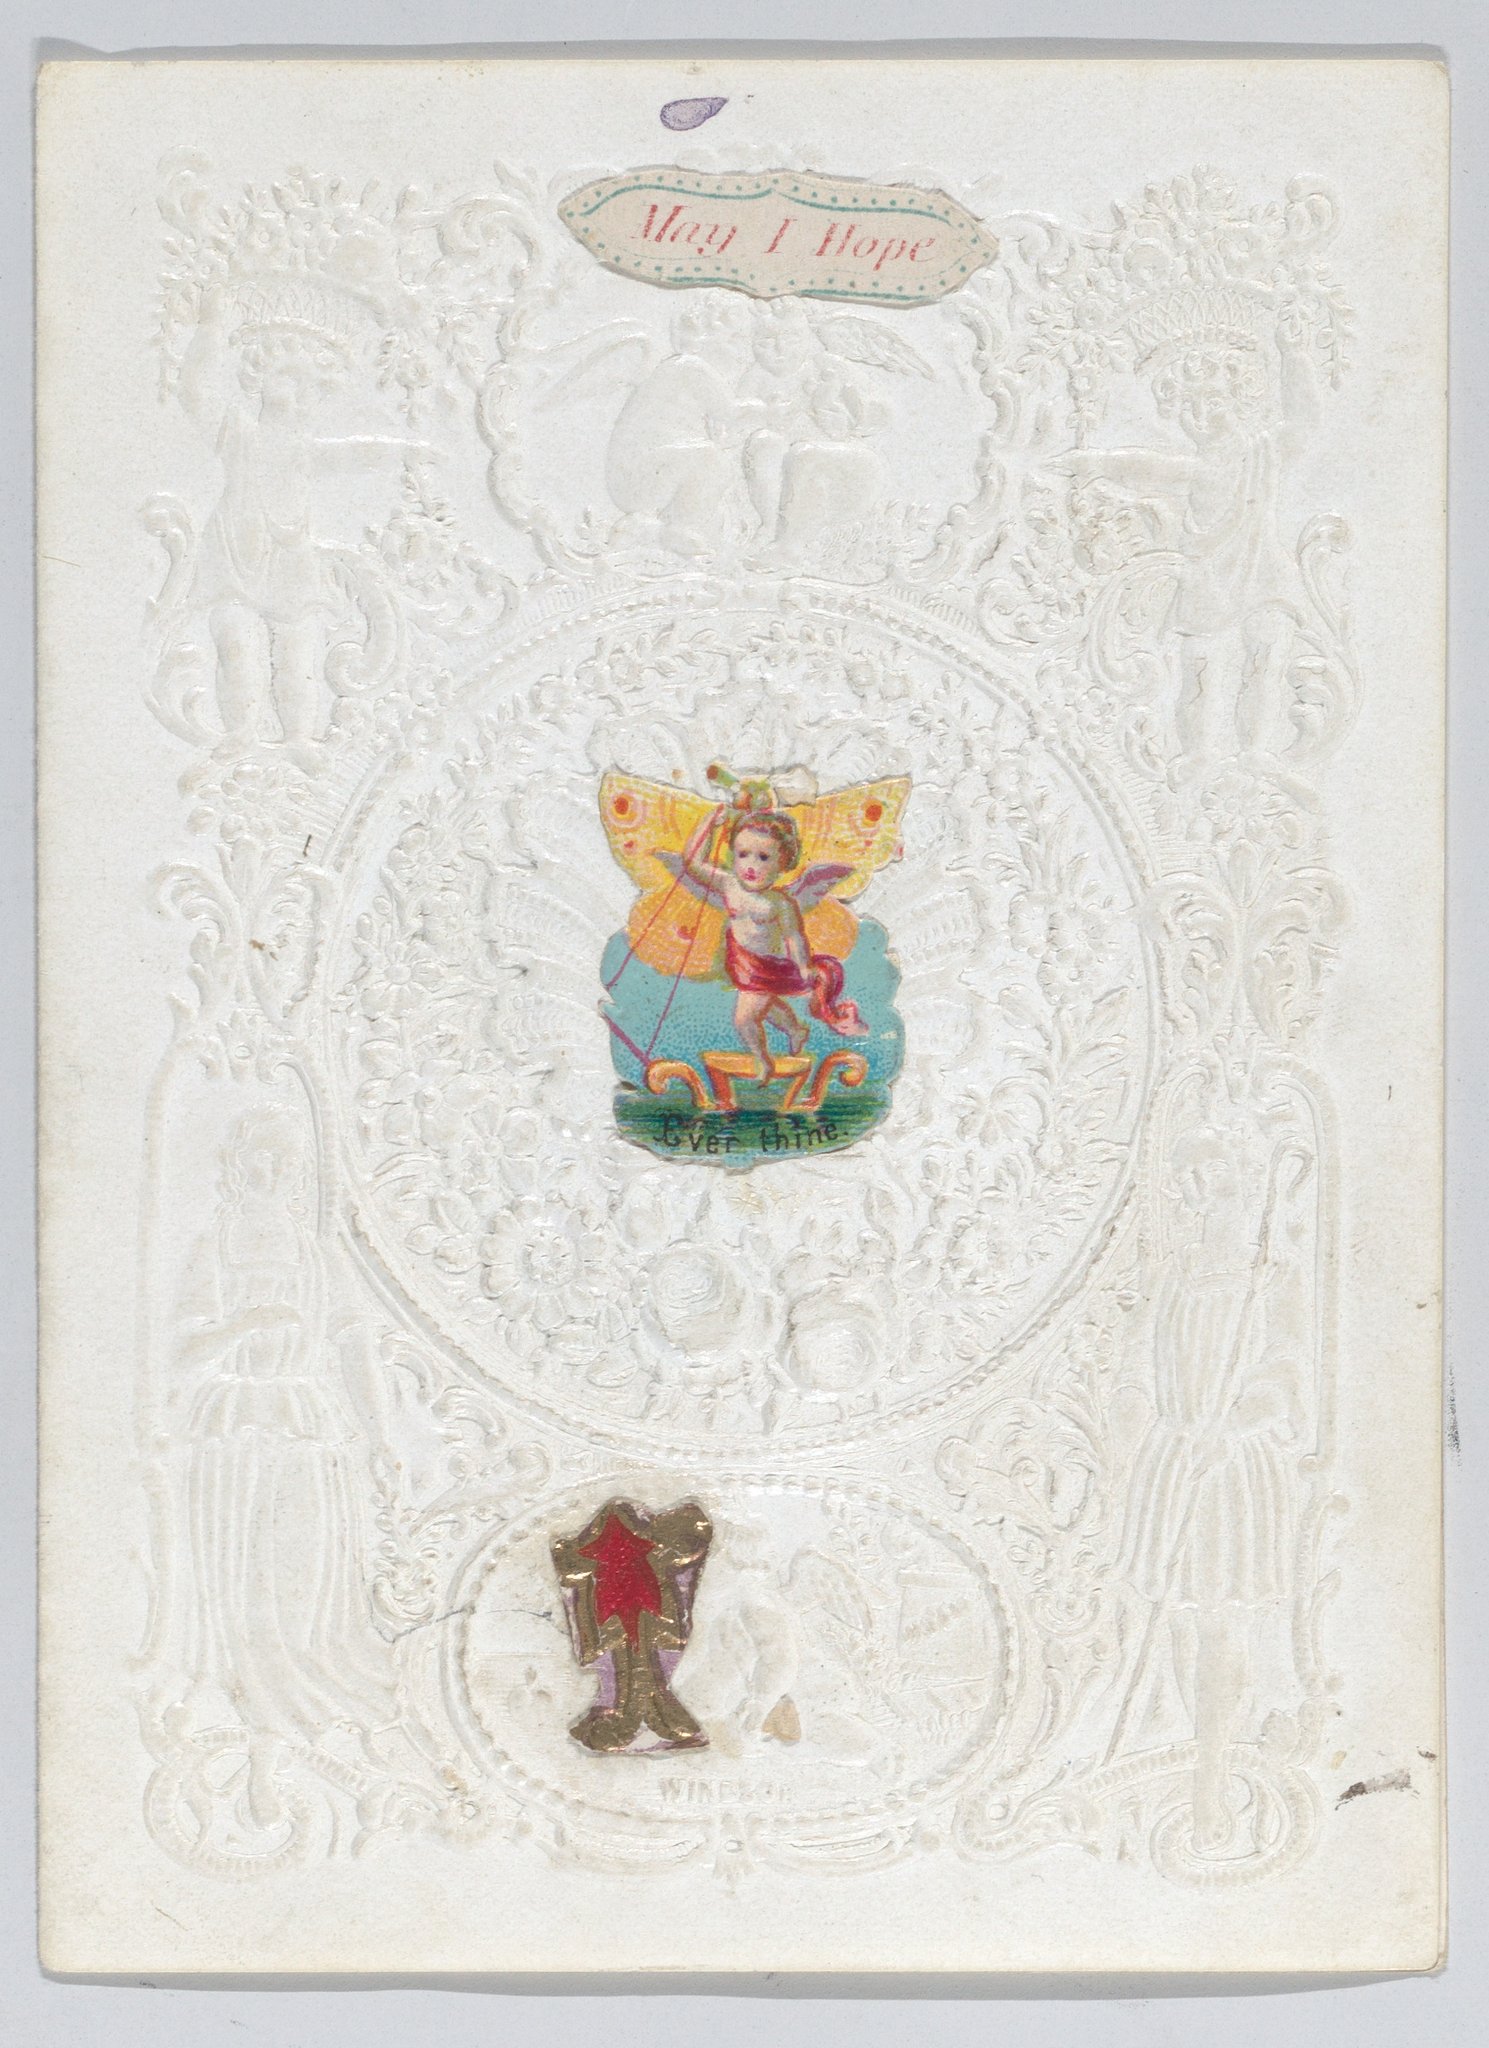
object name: valentine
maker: Anonymous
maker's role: artist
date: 1850-1870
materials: paper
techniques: chromolithography, embossing